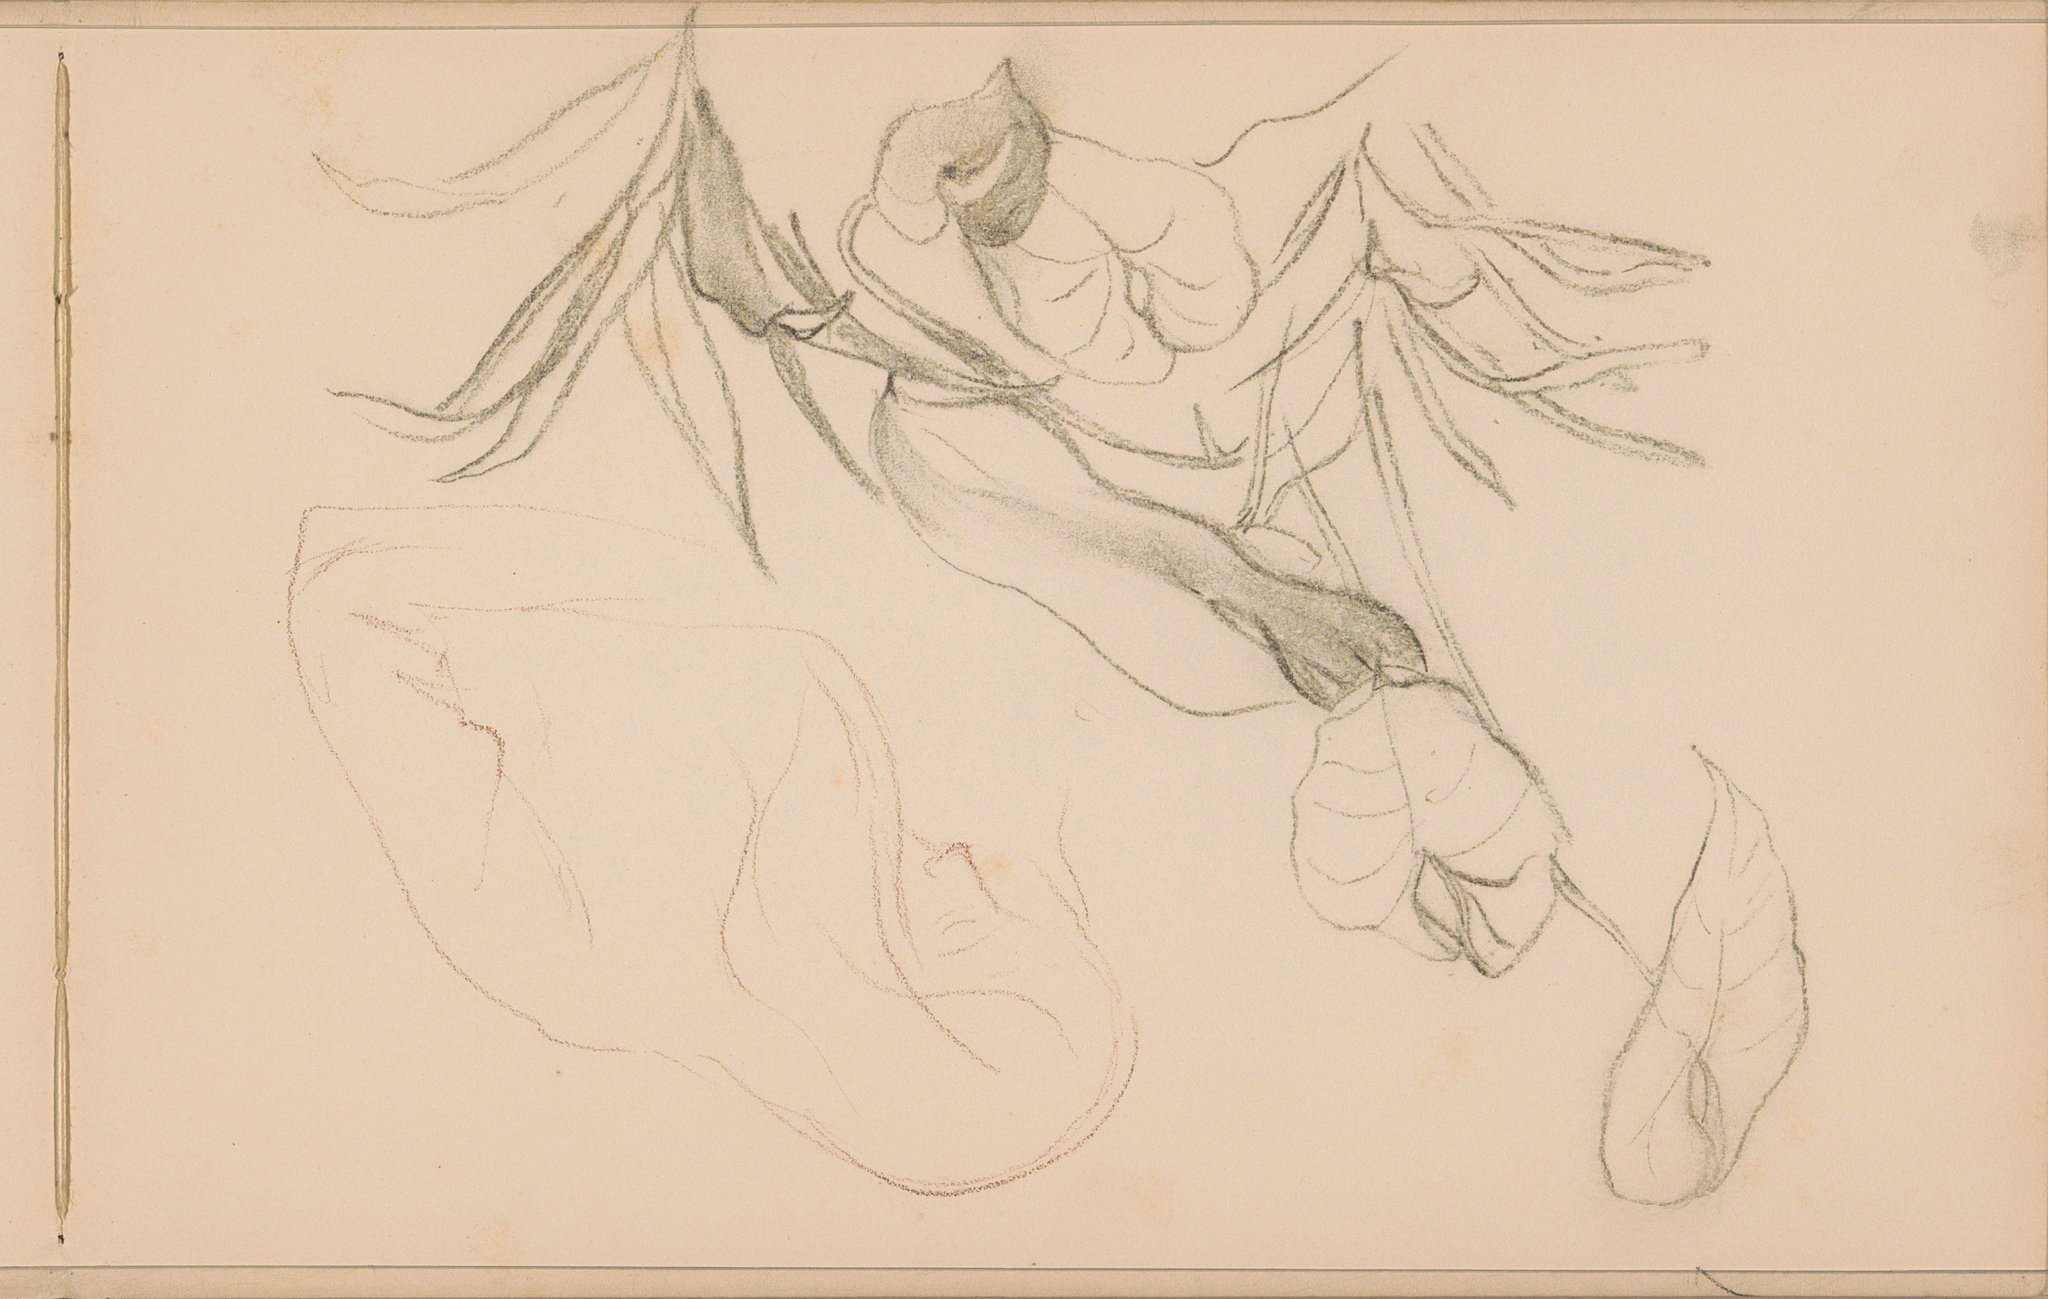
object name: sketchbook leaf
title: Planten en een meisje met lang haar en het hoofd voorovergebogen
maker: a.a.l. de grammont-hubrecht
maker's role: draughtsman, painter, print maker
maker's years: 1855-1913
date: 1865-1913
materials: chalk, charcoal, paper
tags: plants (in general), head bent forward; bowing, girl (child between toddler and youth)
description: Blad 22 recto uit een schetsboek met 65 bladen.